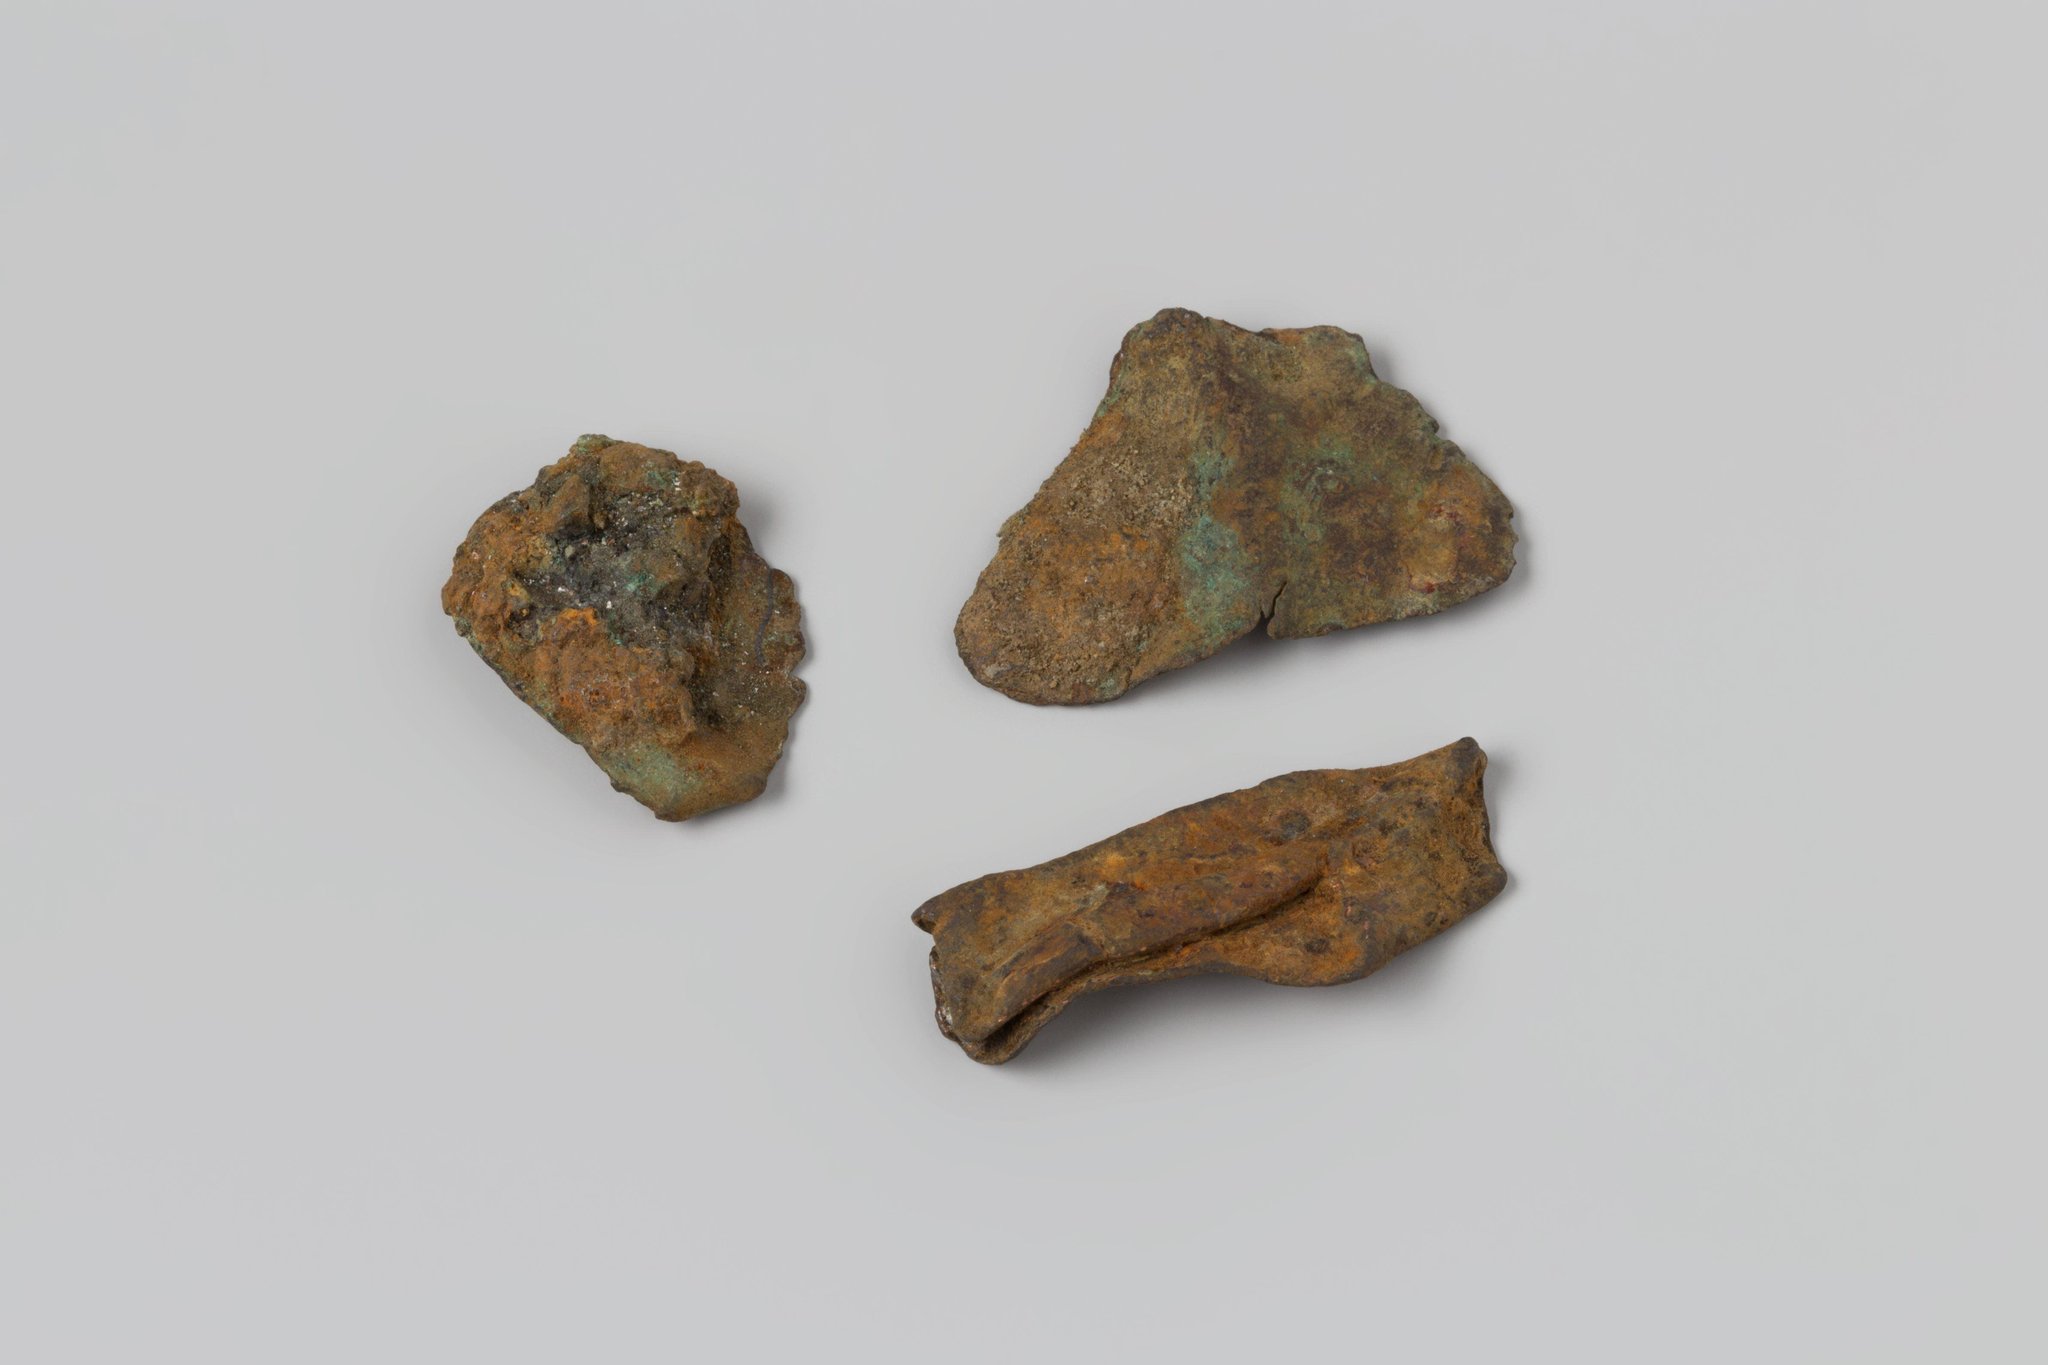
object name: scheepswrakvondst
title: Fragmenten van koper uit het wrak van de Oost-Indiëvaarder Hollandia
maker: Anonymous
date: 1700-1743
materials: copper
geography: netherlands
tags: verenigde oostindische compagnie, hollandia (schip), annet